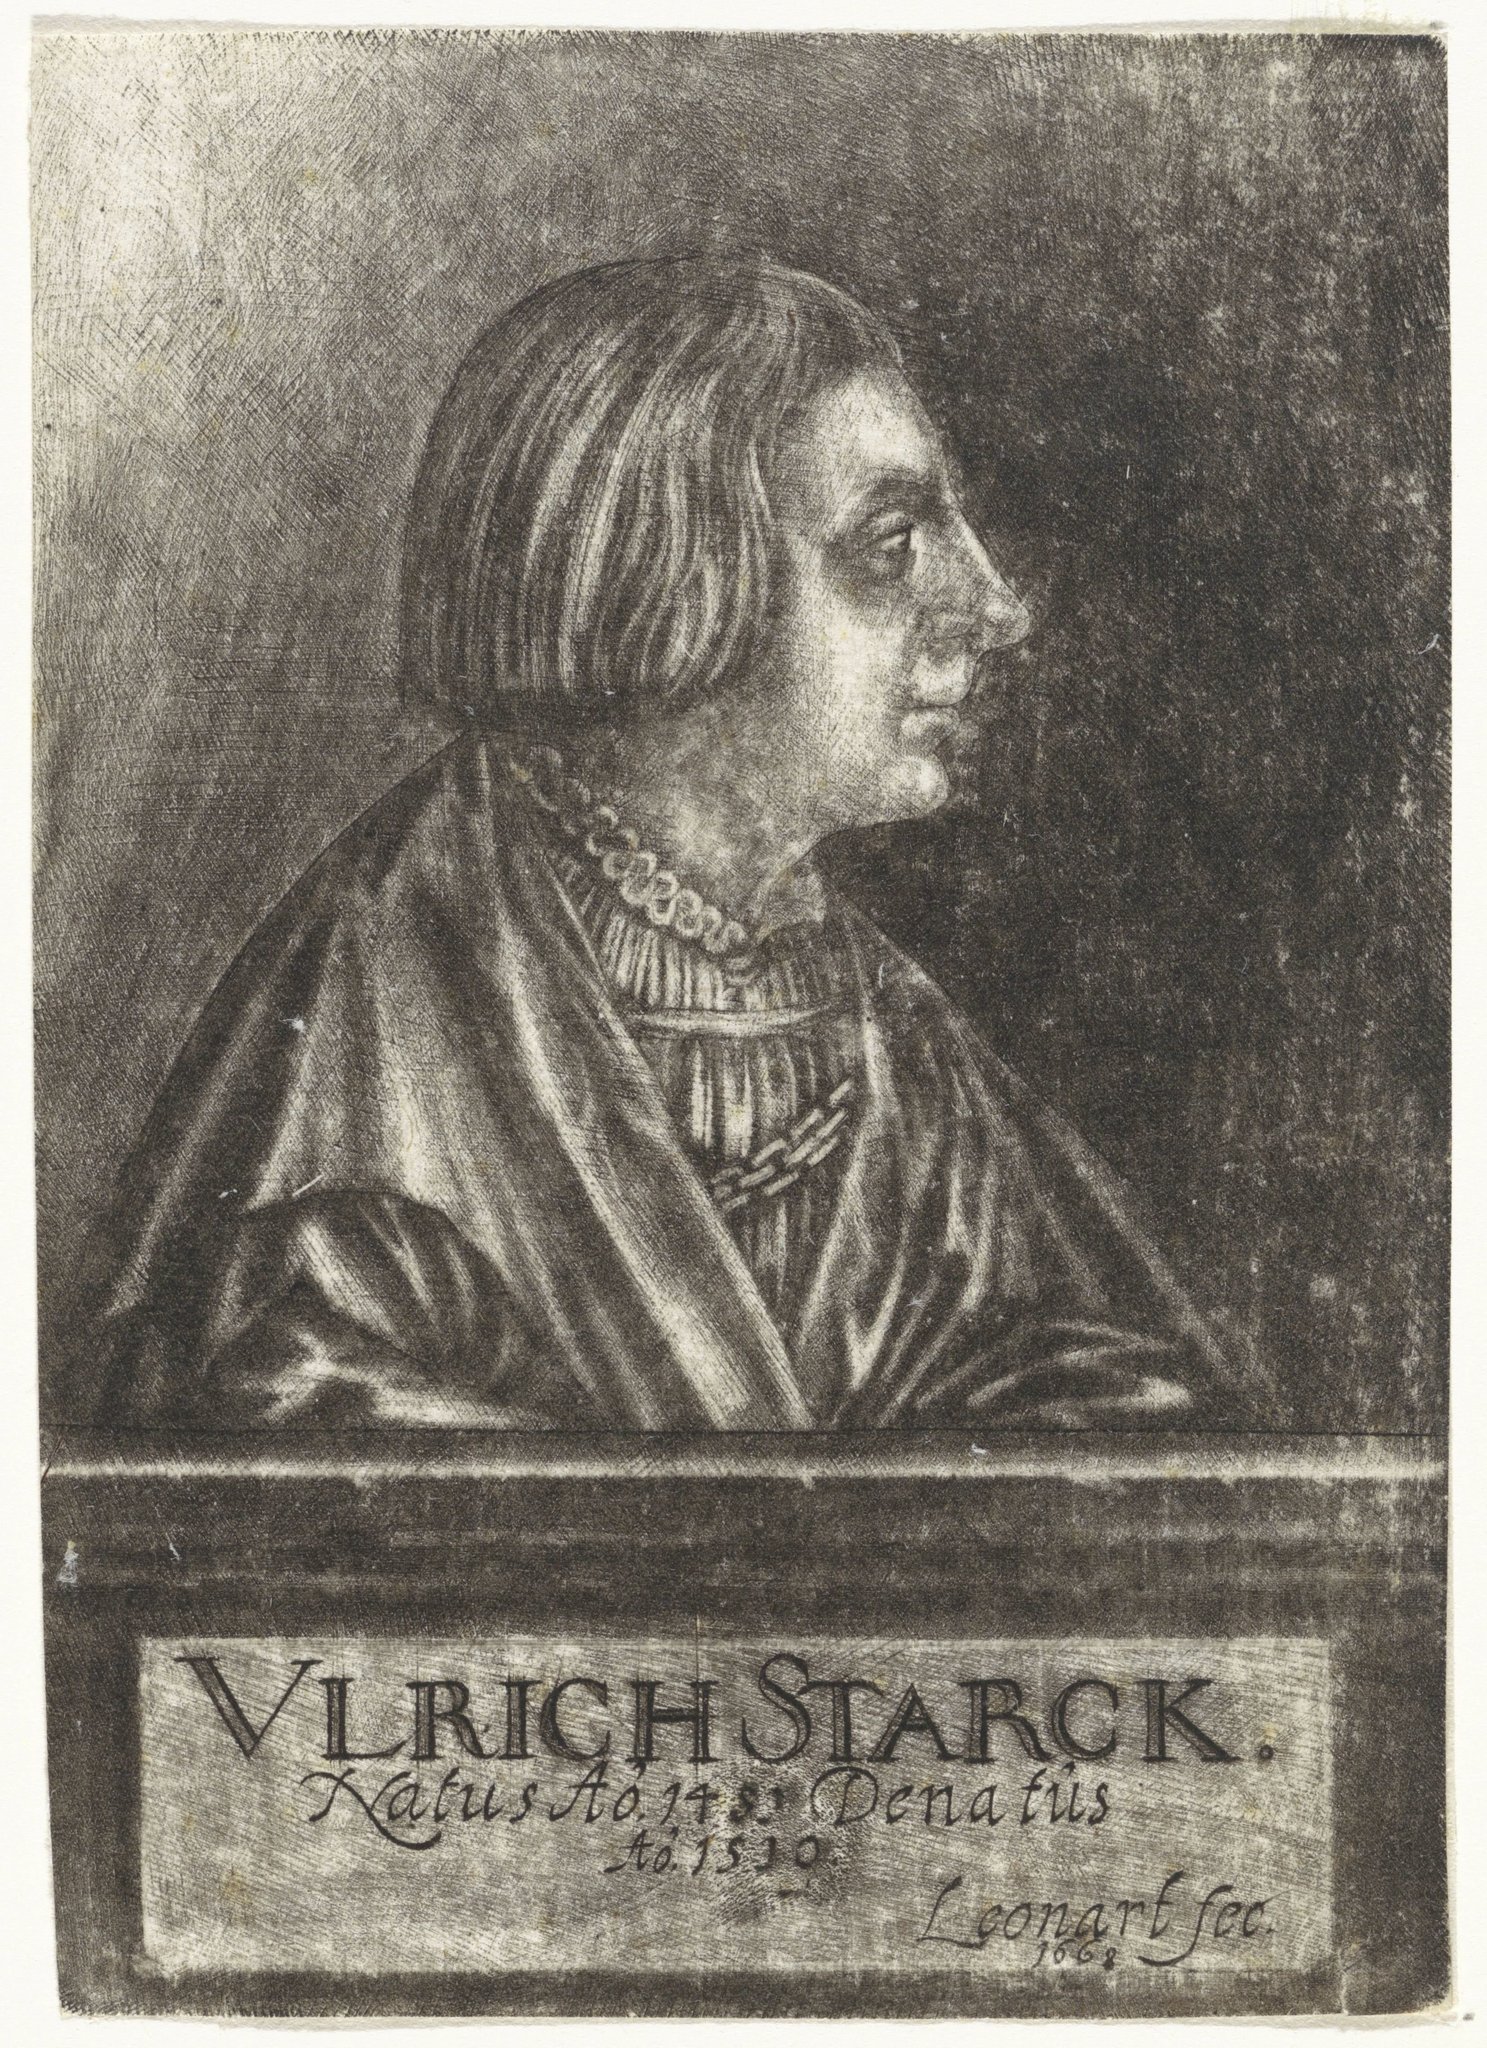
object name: print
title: Portret van Ulrich Starck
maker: johann friedrich leonard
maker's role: print maker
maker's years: 1633-1680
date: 1668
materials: paper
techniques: engraving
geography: nuremberg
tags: ulrich starck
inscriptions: collector's mark: Lugt 2228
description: De patriciër uit Neurenberg Ulrich Starck, in profiel.